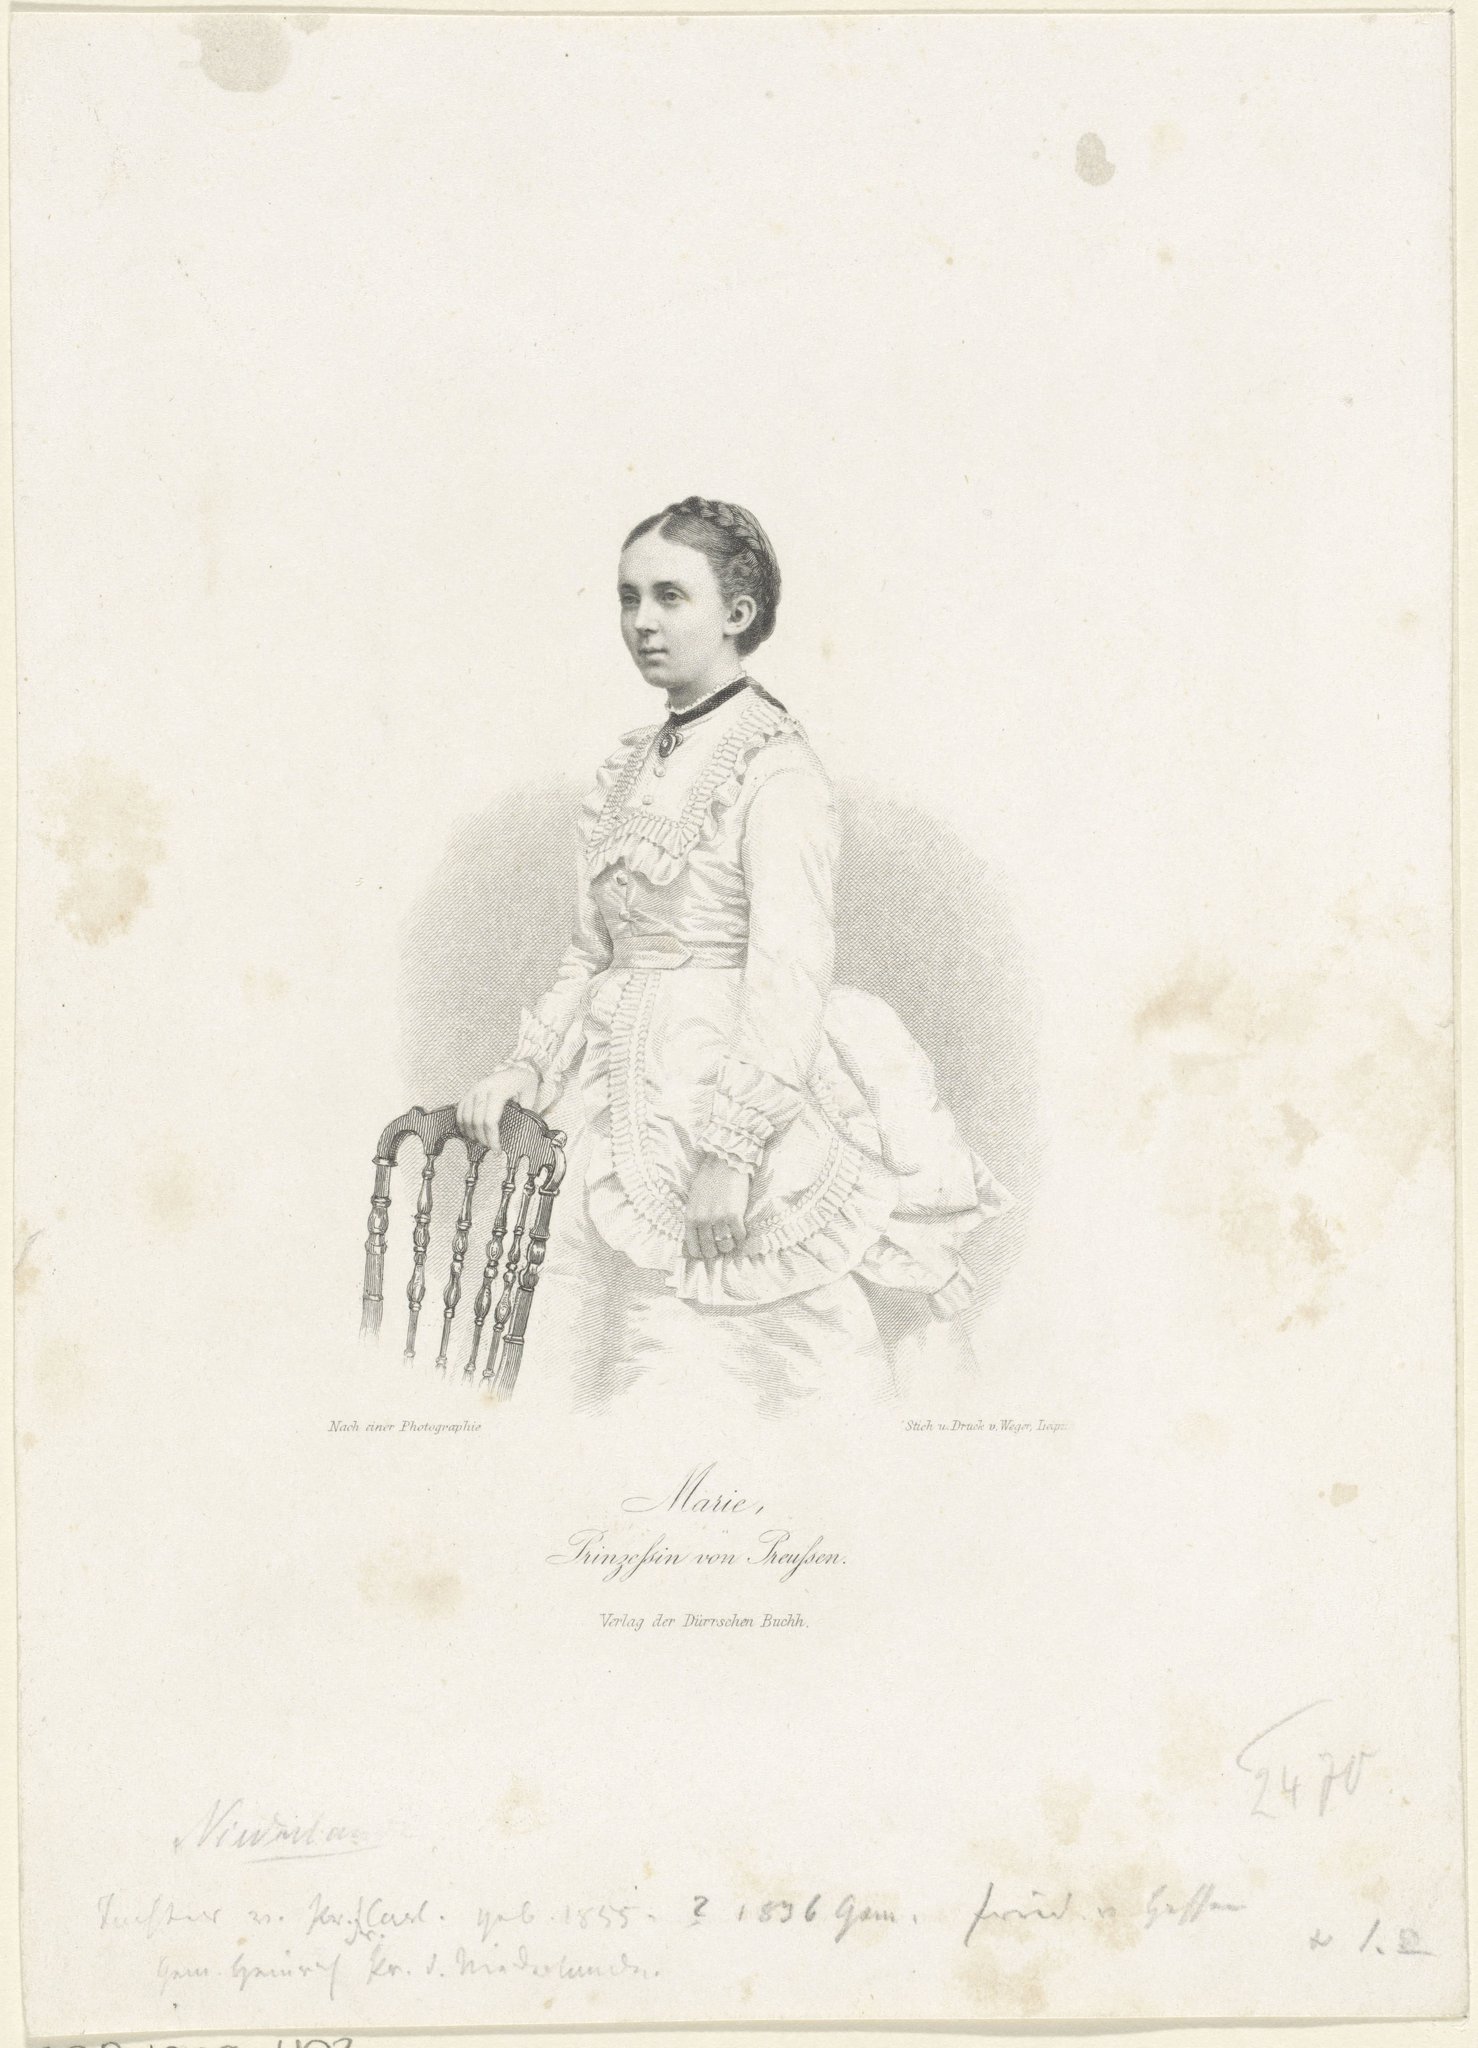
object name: print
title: Portret van Maria van Pruisen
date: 1870-1909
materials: paper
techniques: engraving, etching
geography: leipzig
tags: dresden, prinses, maria van pruisen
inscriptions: collector's mark: Lugt 2228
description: Portret van Maria van Pruisen. Onder haar rechterhand een stoel. In de ondermarge haar naam en titel.